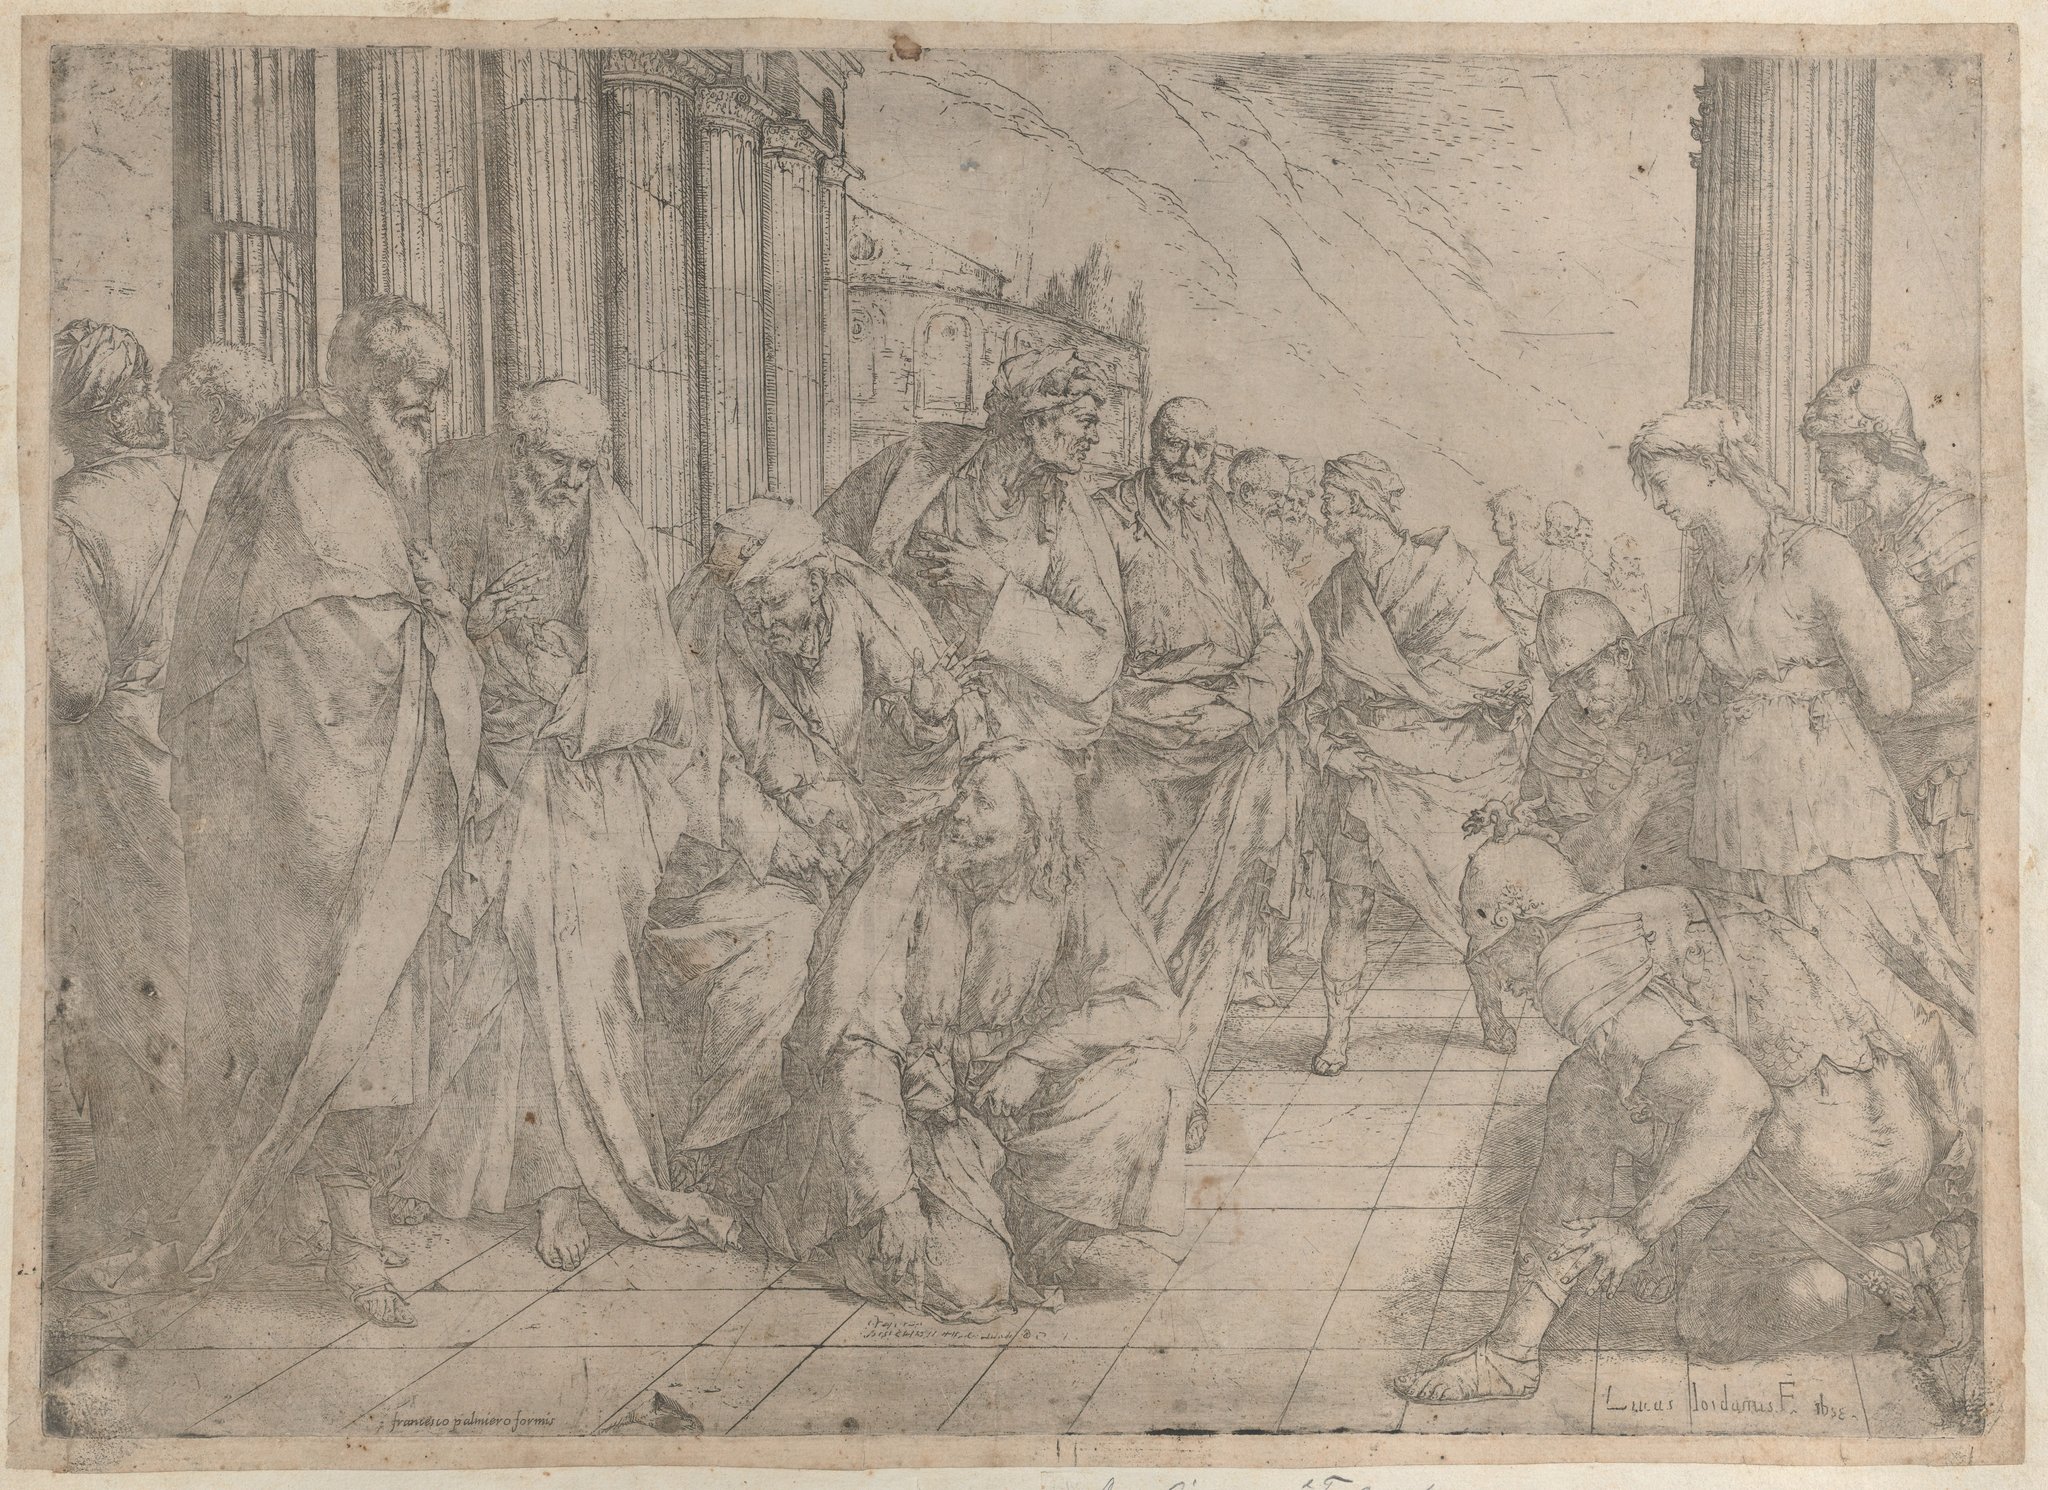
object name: print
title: Christ kneels and writes on the pavement at center, while the woman taken in adultery stands between three soldiers at right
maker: luca giordano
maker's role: artist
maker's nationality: italian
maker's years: 1634-1705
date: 1653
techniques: etching